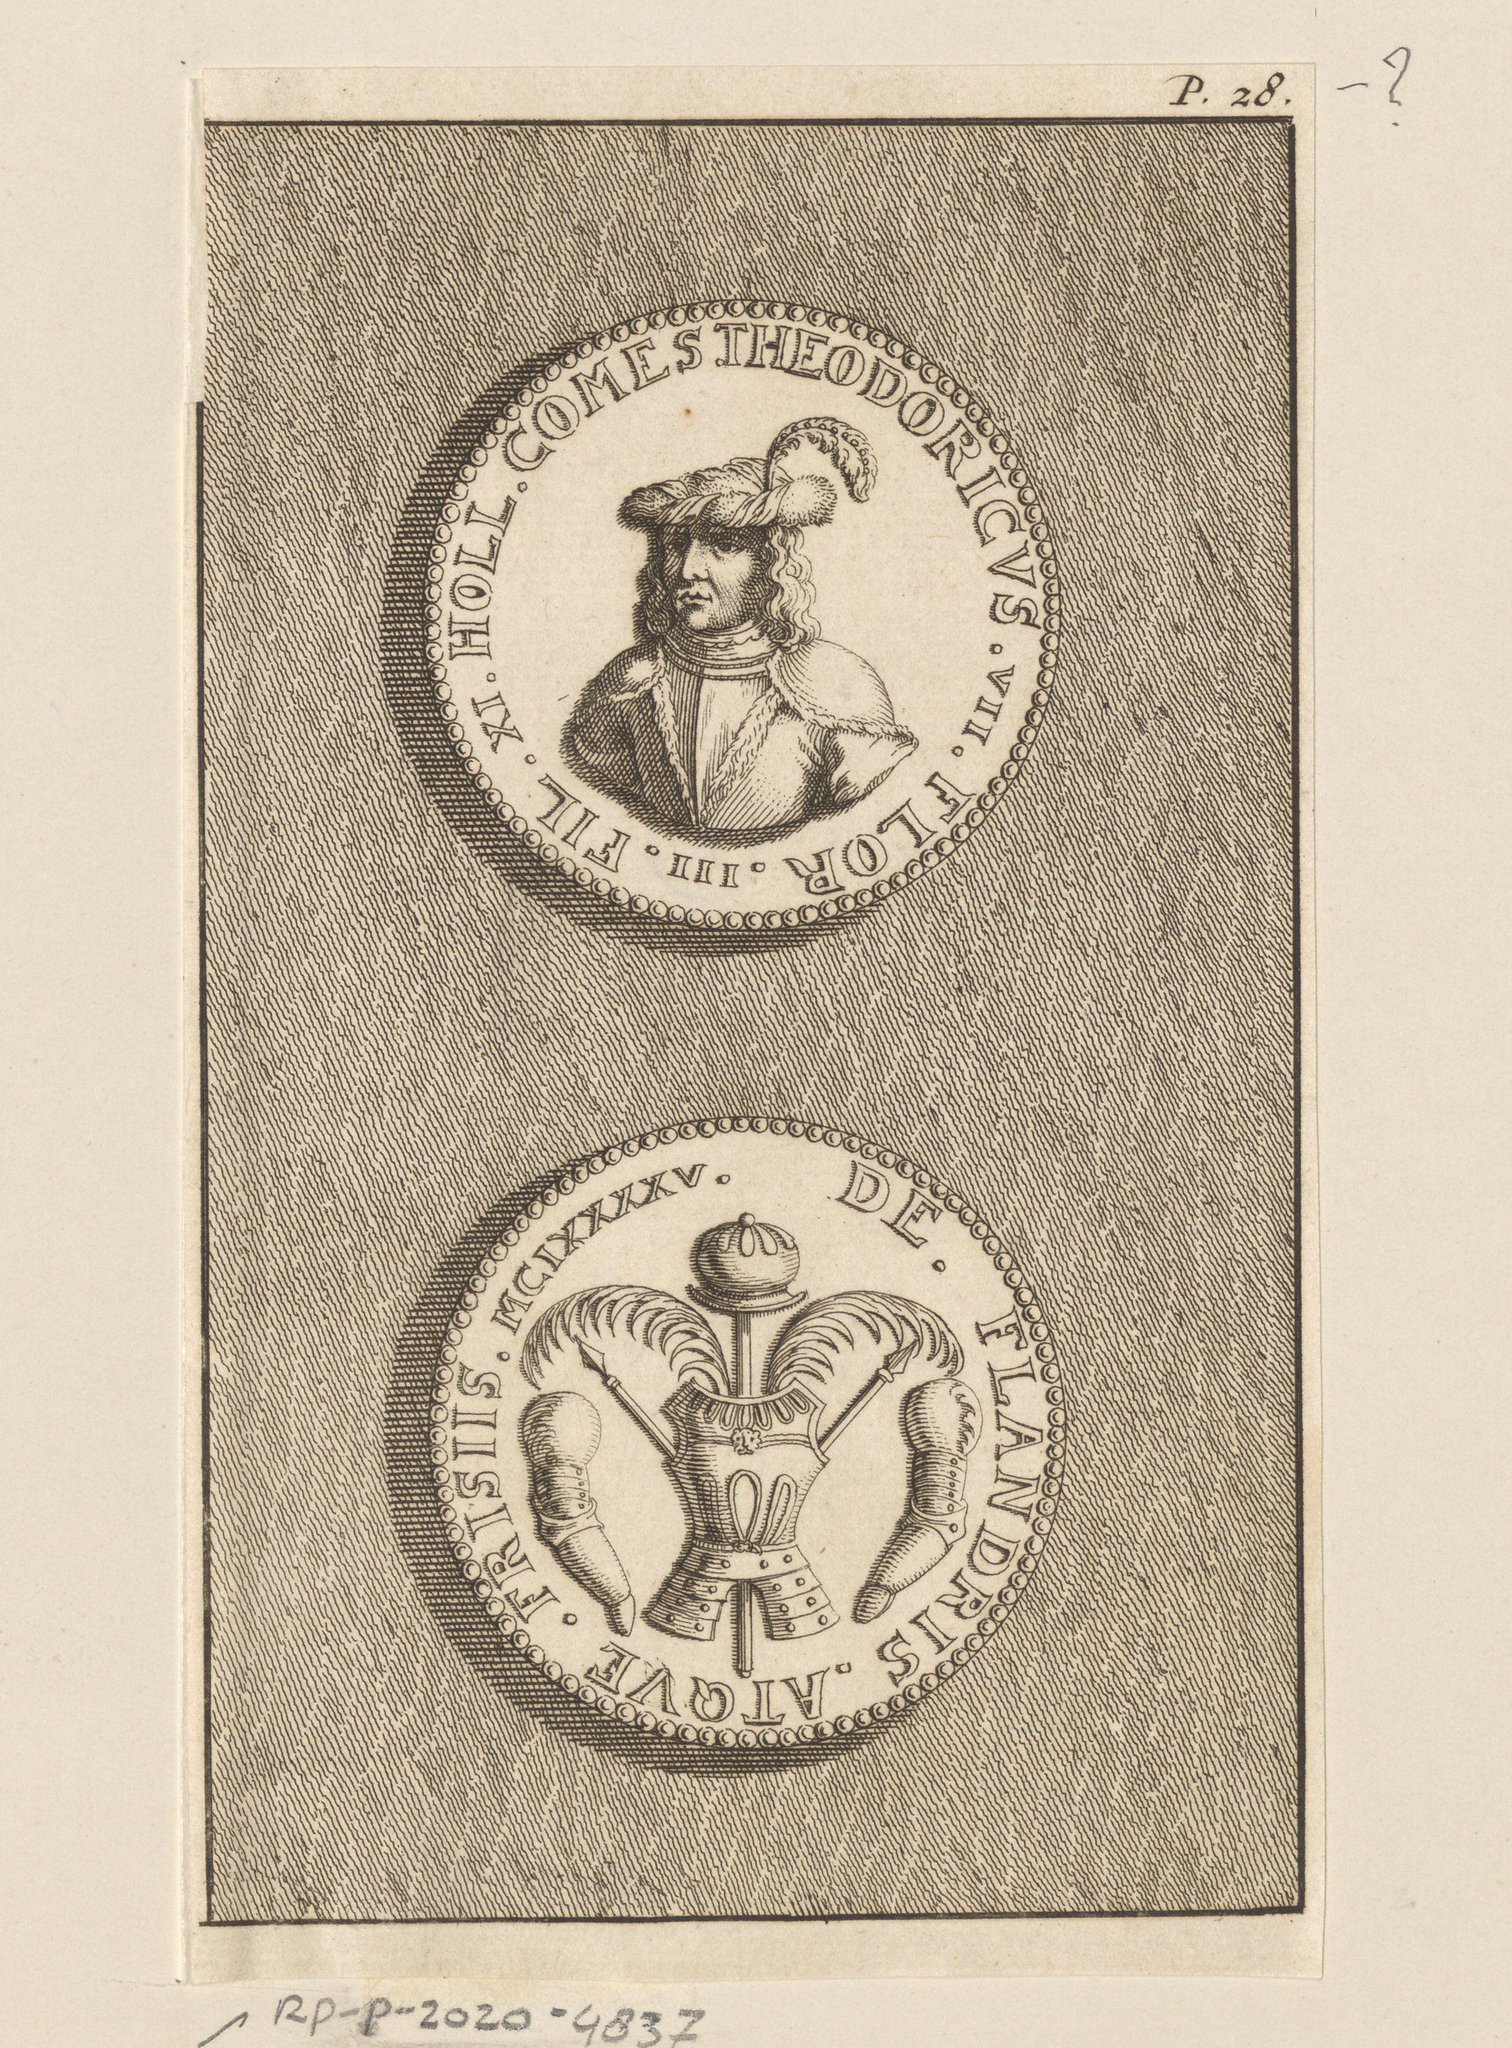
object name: print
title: Portret van Dirk VII, graaf van Holland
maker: Anonymous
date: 1650-1749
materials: paper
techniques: etching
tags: dordrecht, armour, historical persons, head-gear: hat, ruler, sovereign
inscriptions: collector's mark: Lugt 964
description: In een medaillon. Onder het portret een tweede medaillon met daarin enkele attributen waaronder een kroon en een mijter. Rechtsboven genummerd: P. 28.